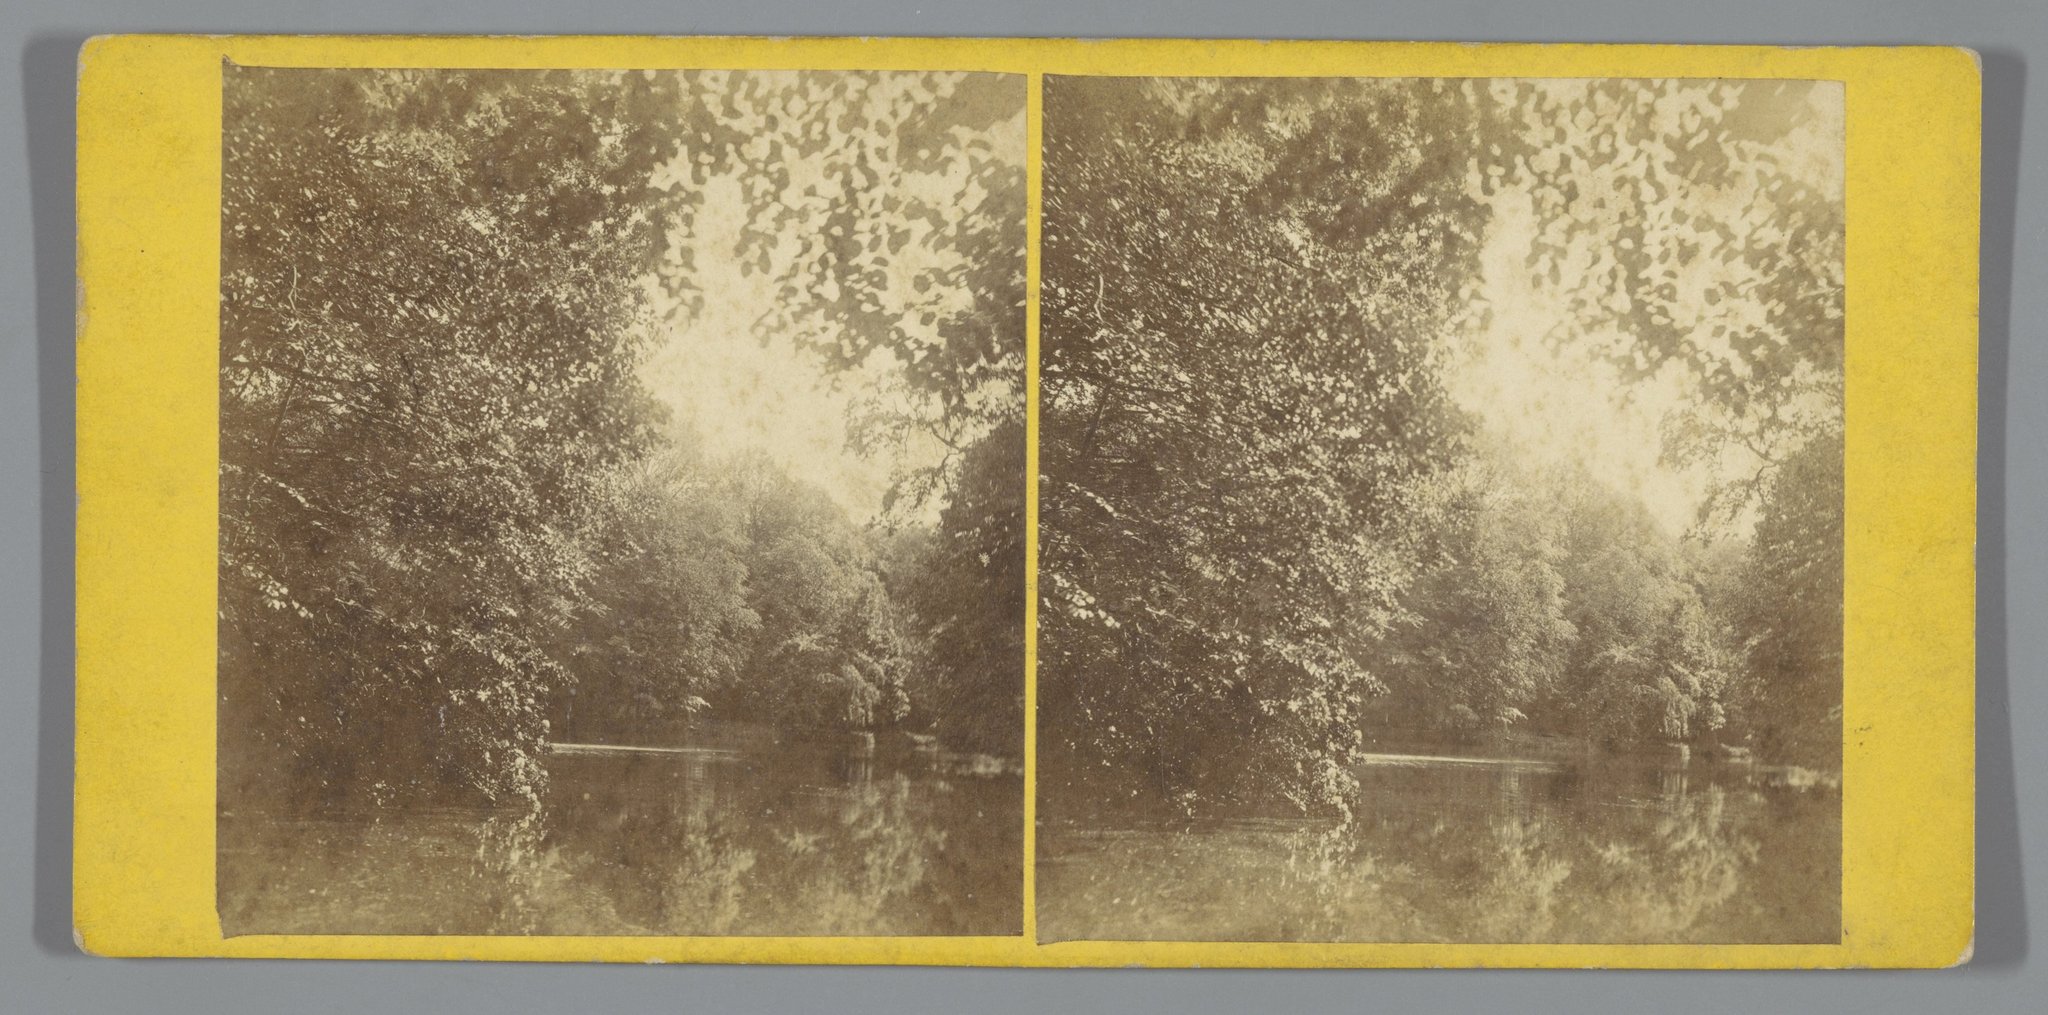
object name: stereograph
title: Vijver in het Haagse Bos, Den Haag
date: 1861-1870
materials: cardboard, paper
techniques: albumen print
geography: the hague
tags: park, pond, pool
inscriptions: inscription: ‘C. H. A.: MIRANDE/ S.HAGE/ LANGE POOTEN 21’, number: ‘45’, inscription: ‘A. DE GOEDEREN/ GOUDA’